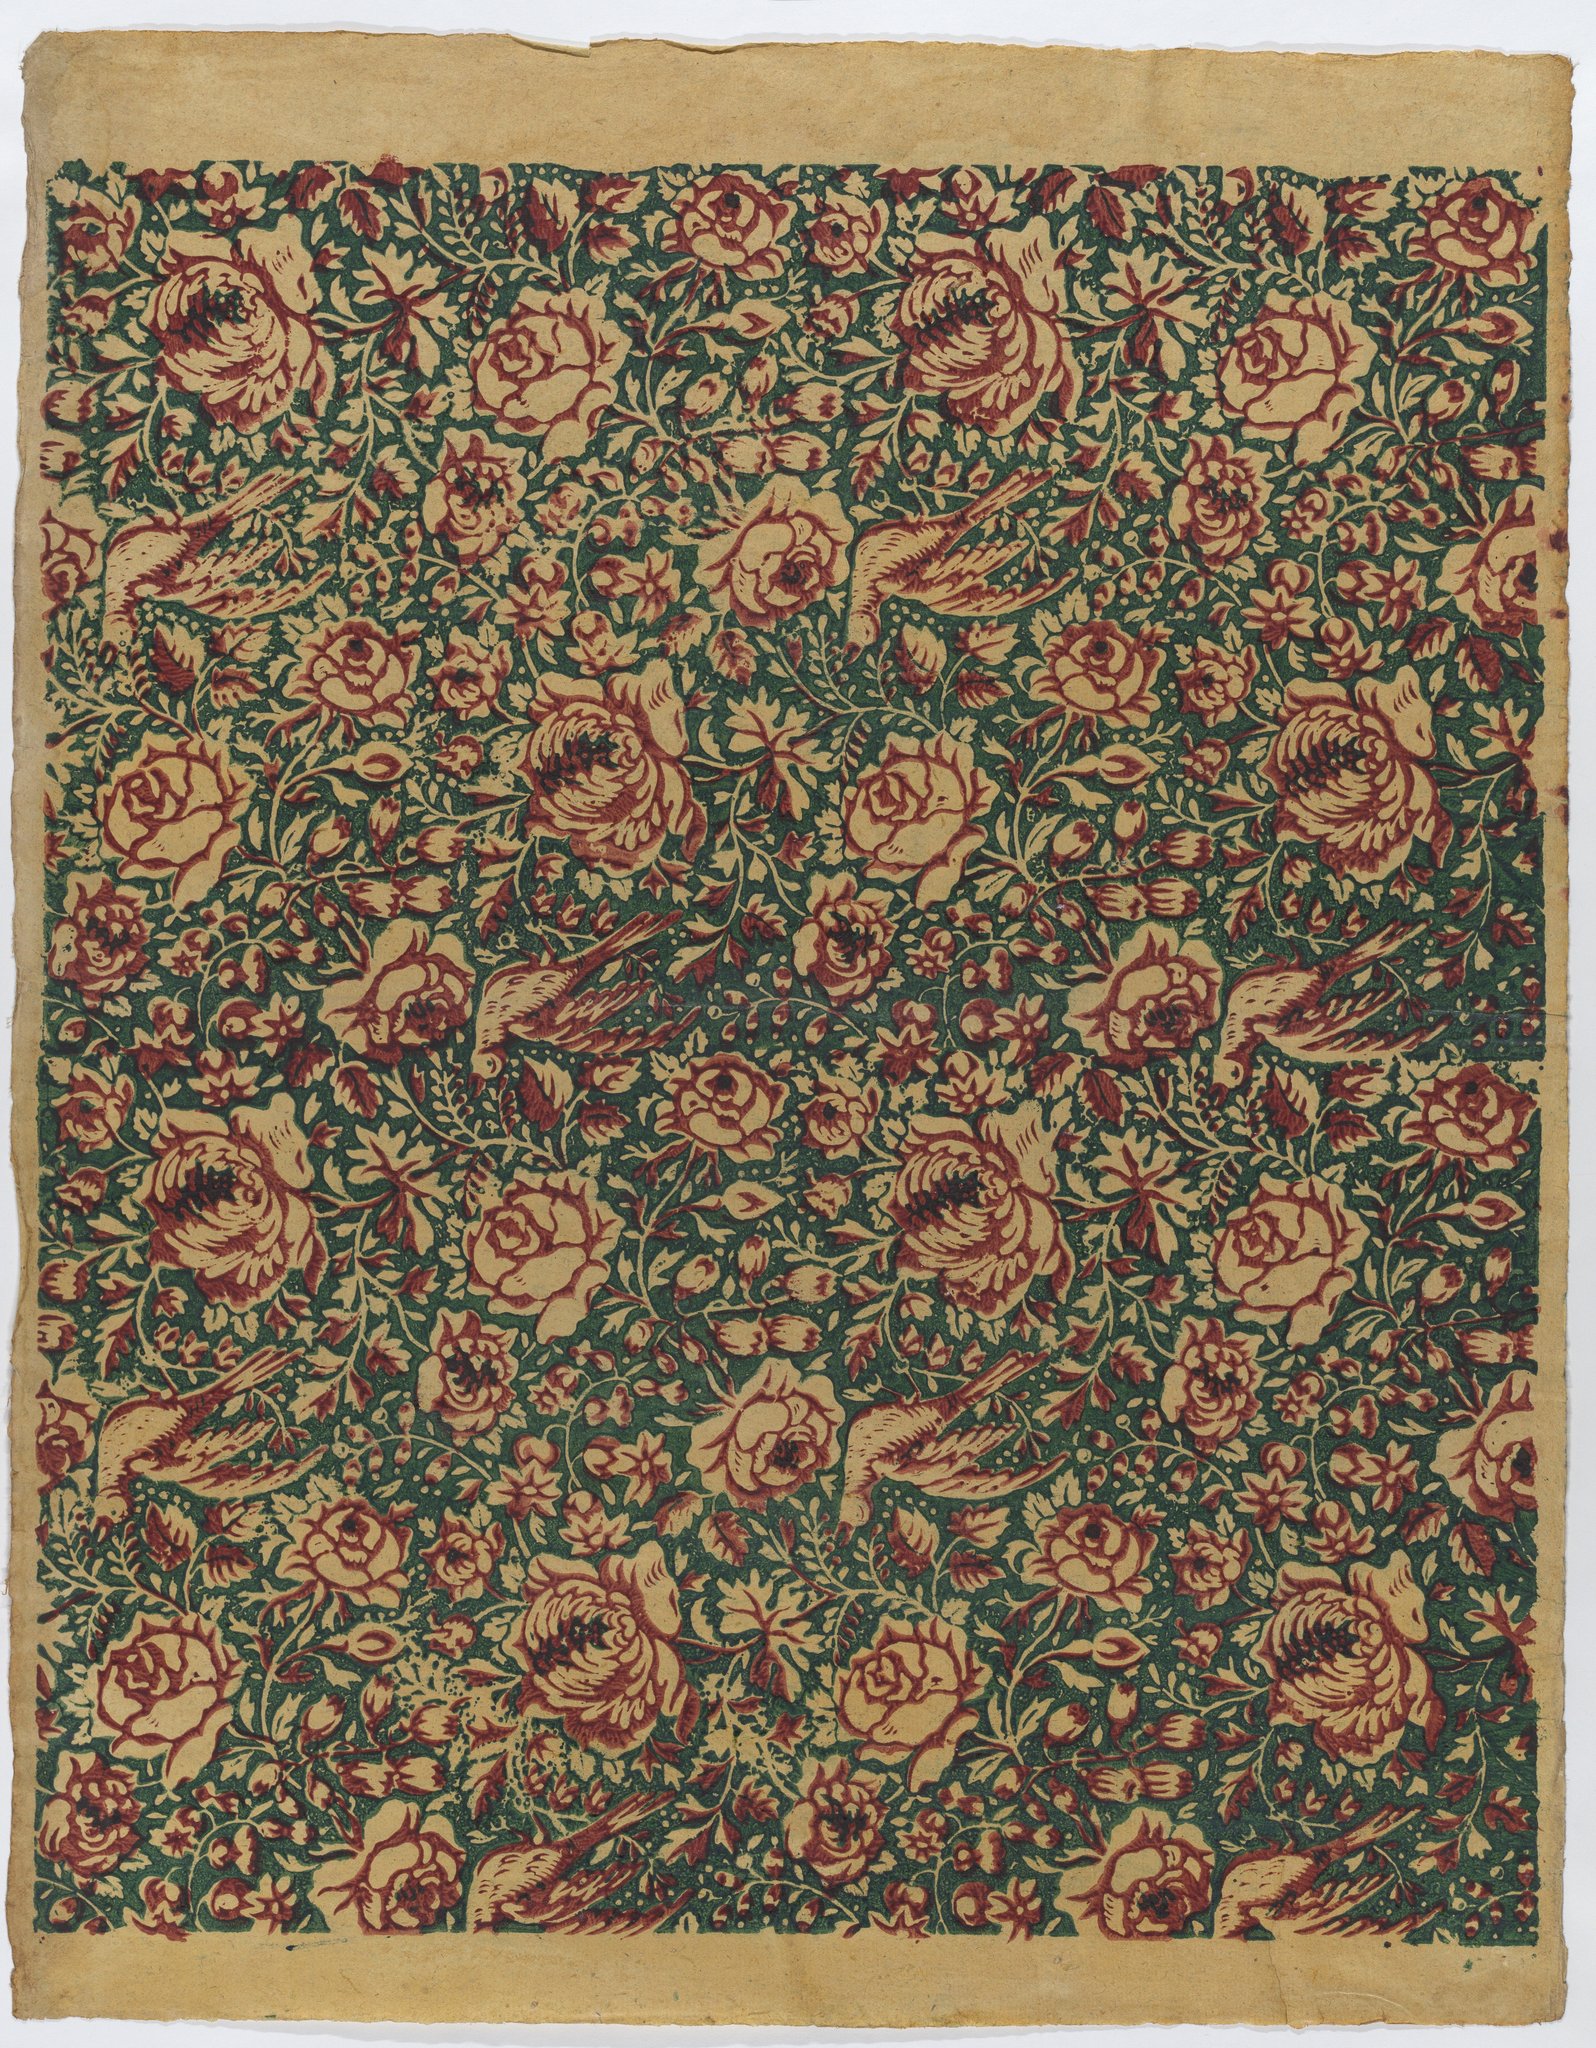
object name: print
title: Sheet with overall floral pattern with birds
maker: Anonymous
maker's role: artist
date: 1767-1866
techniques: relief print